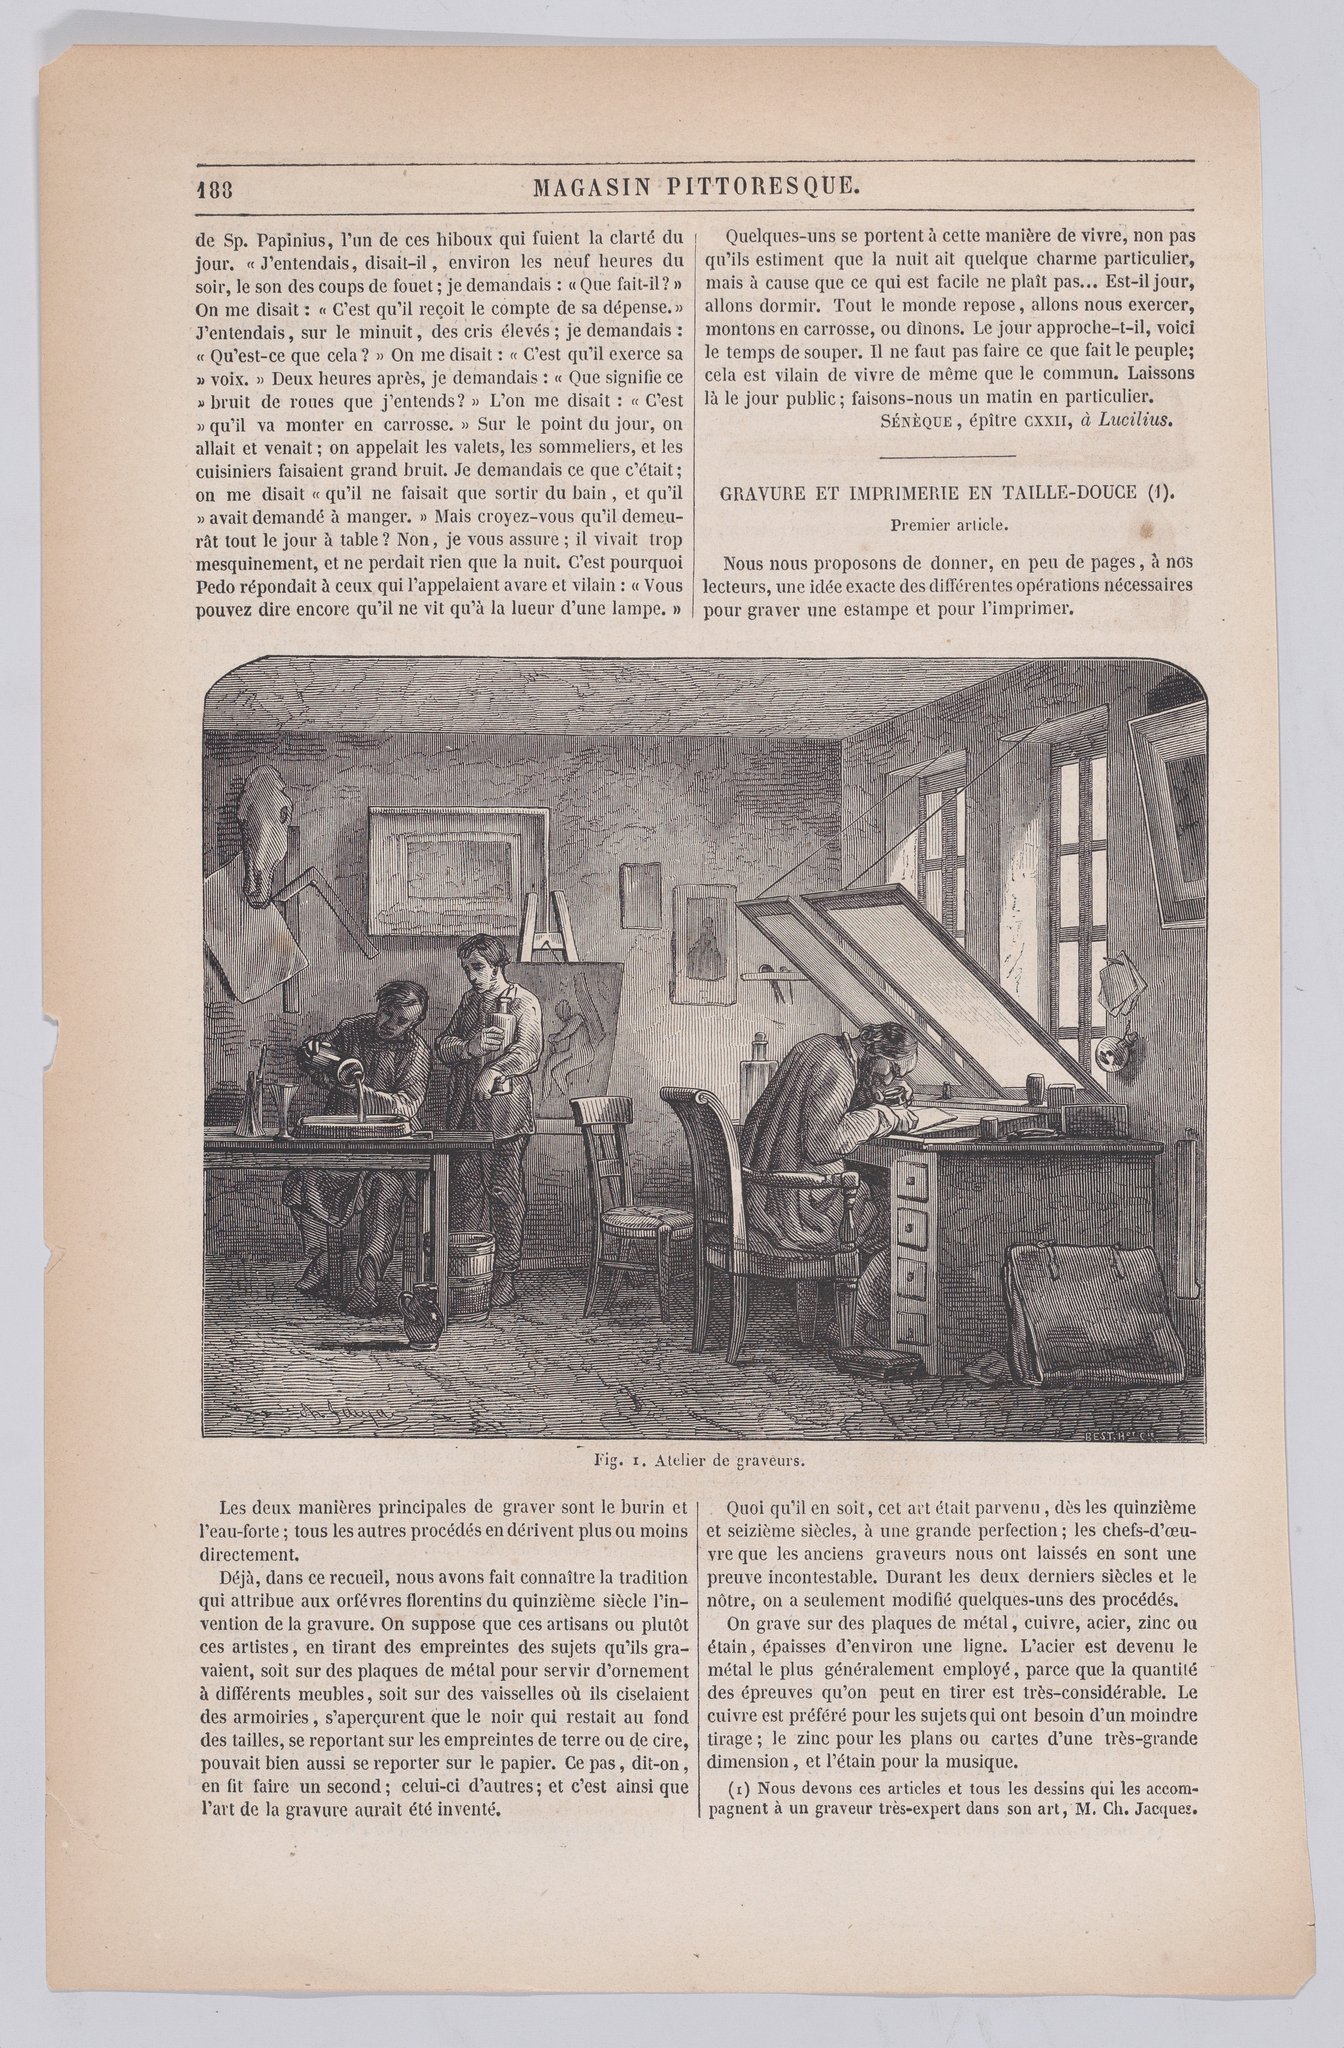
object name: print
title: Engravers' Studio, from "Le Magasin Pittoresque"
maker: charles émile jacque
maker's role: artist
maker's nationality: french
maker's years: 1813-1894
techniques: engraving